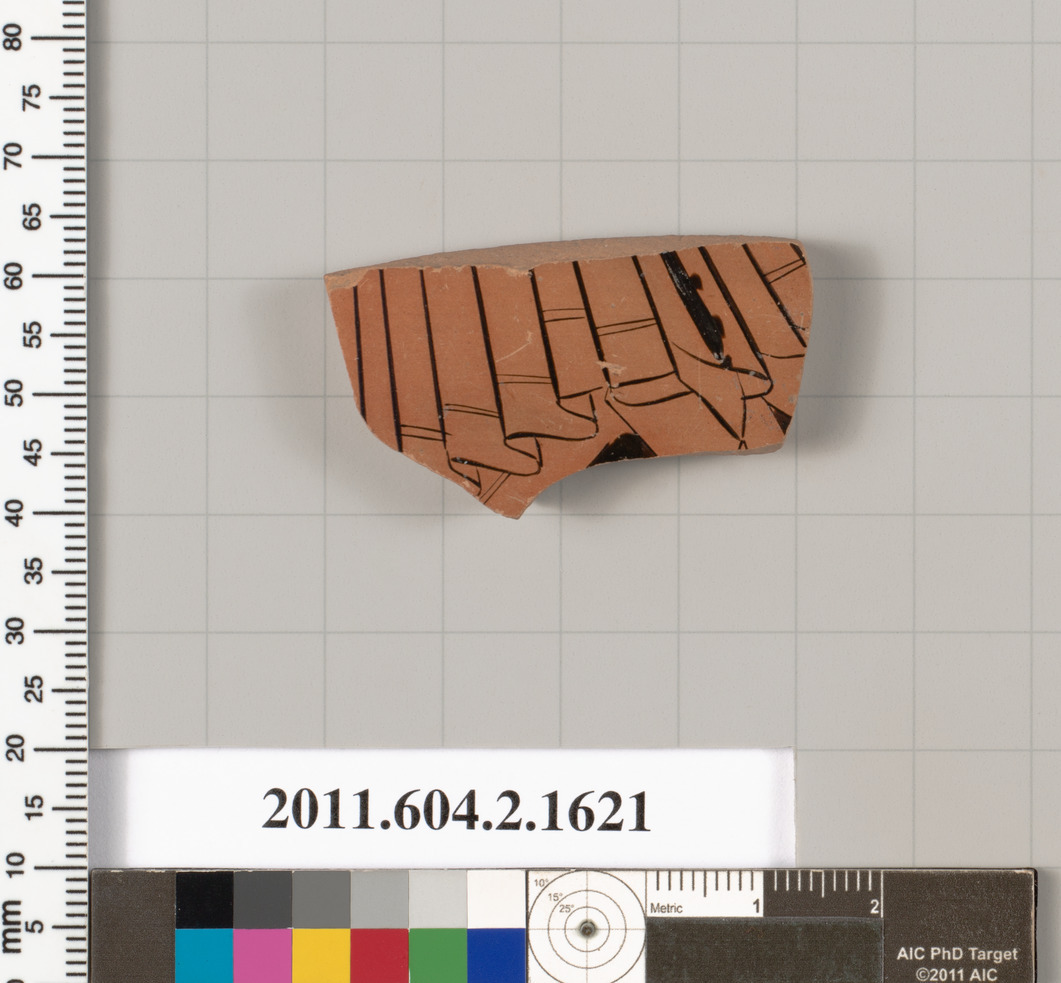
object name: skyphos fragment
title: Terracotta fragment of a skyphos (deep drinking cup)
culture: greek, attic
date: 490-470 BCE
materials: terracotta